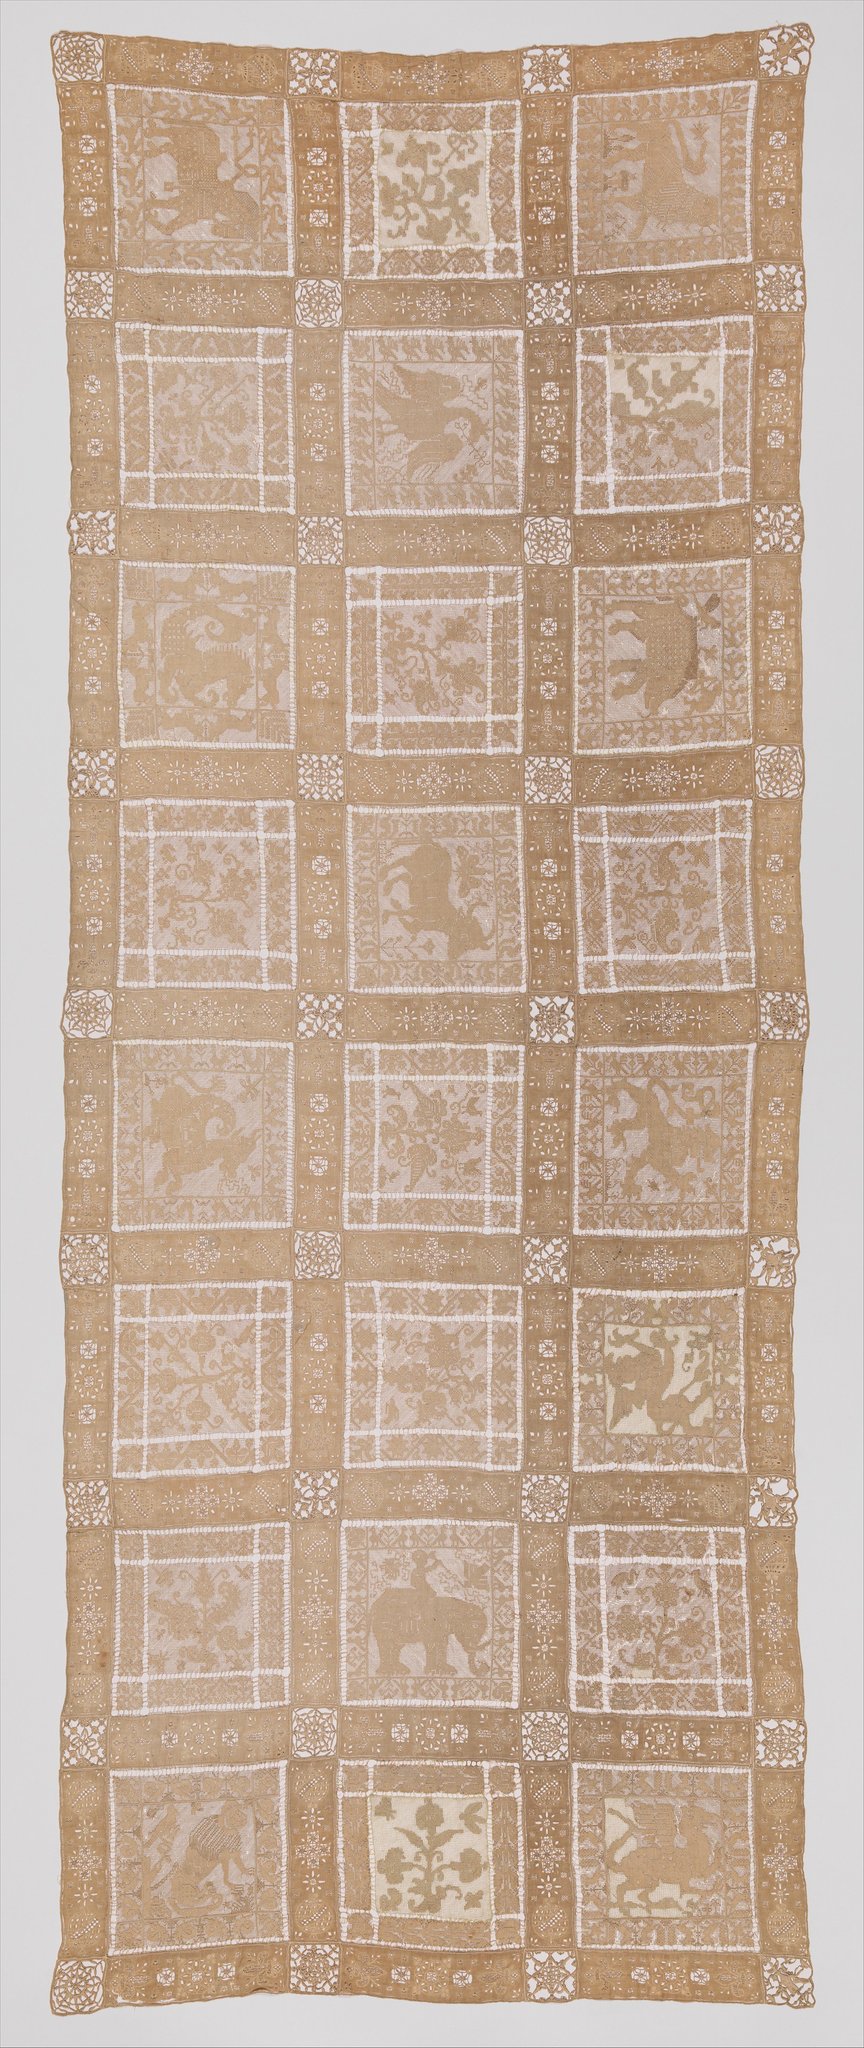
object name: cover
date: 1551-1600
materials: linen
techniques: embroidery, lace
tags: animals